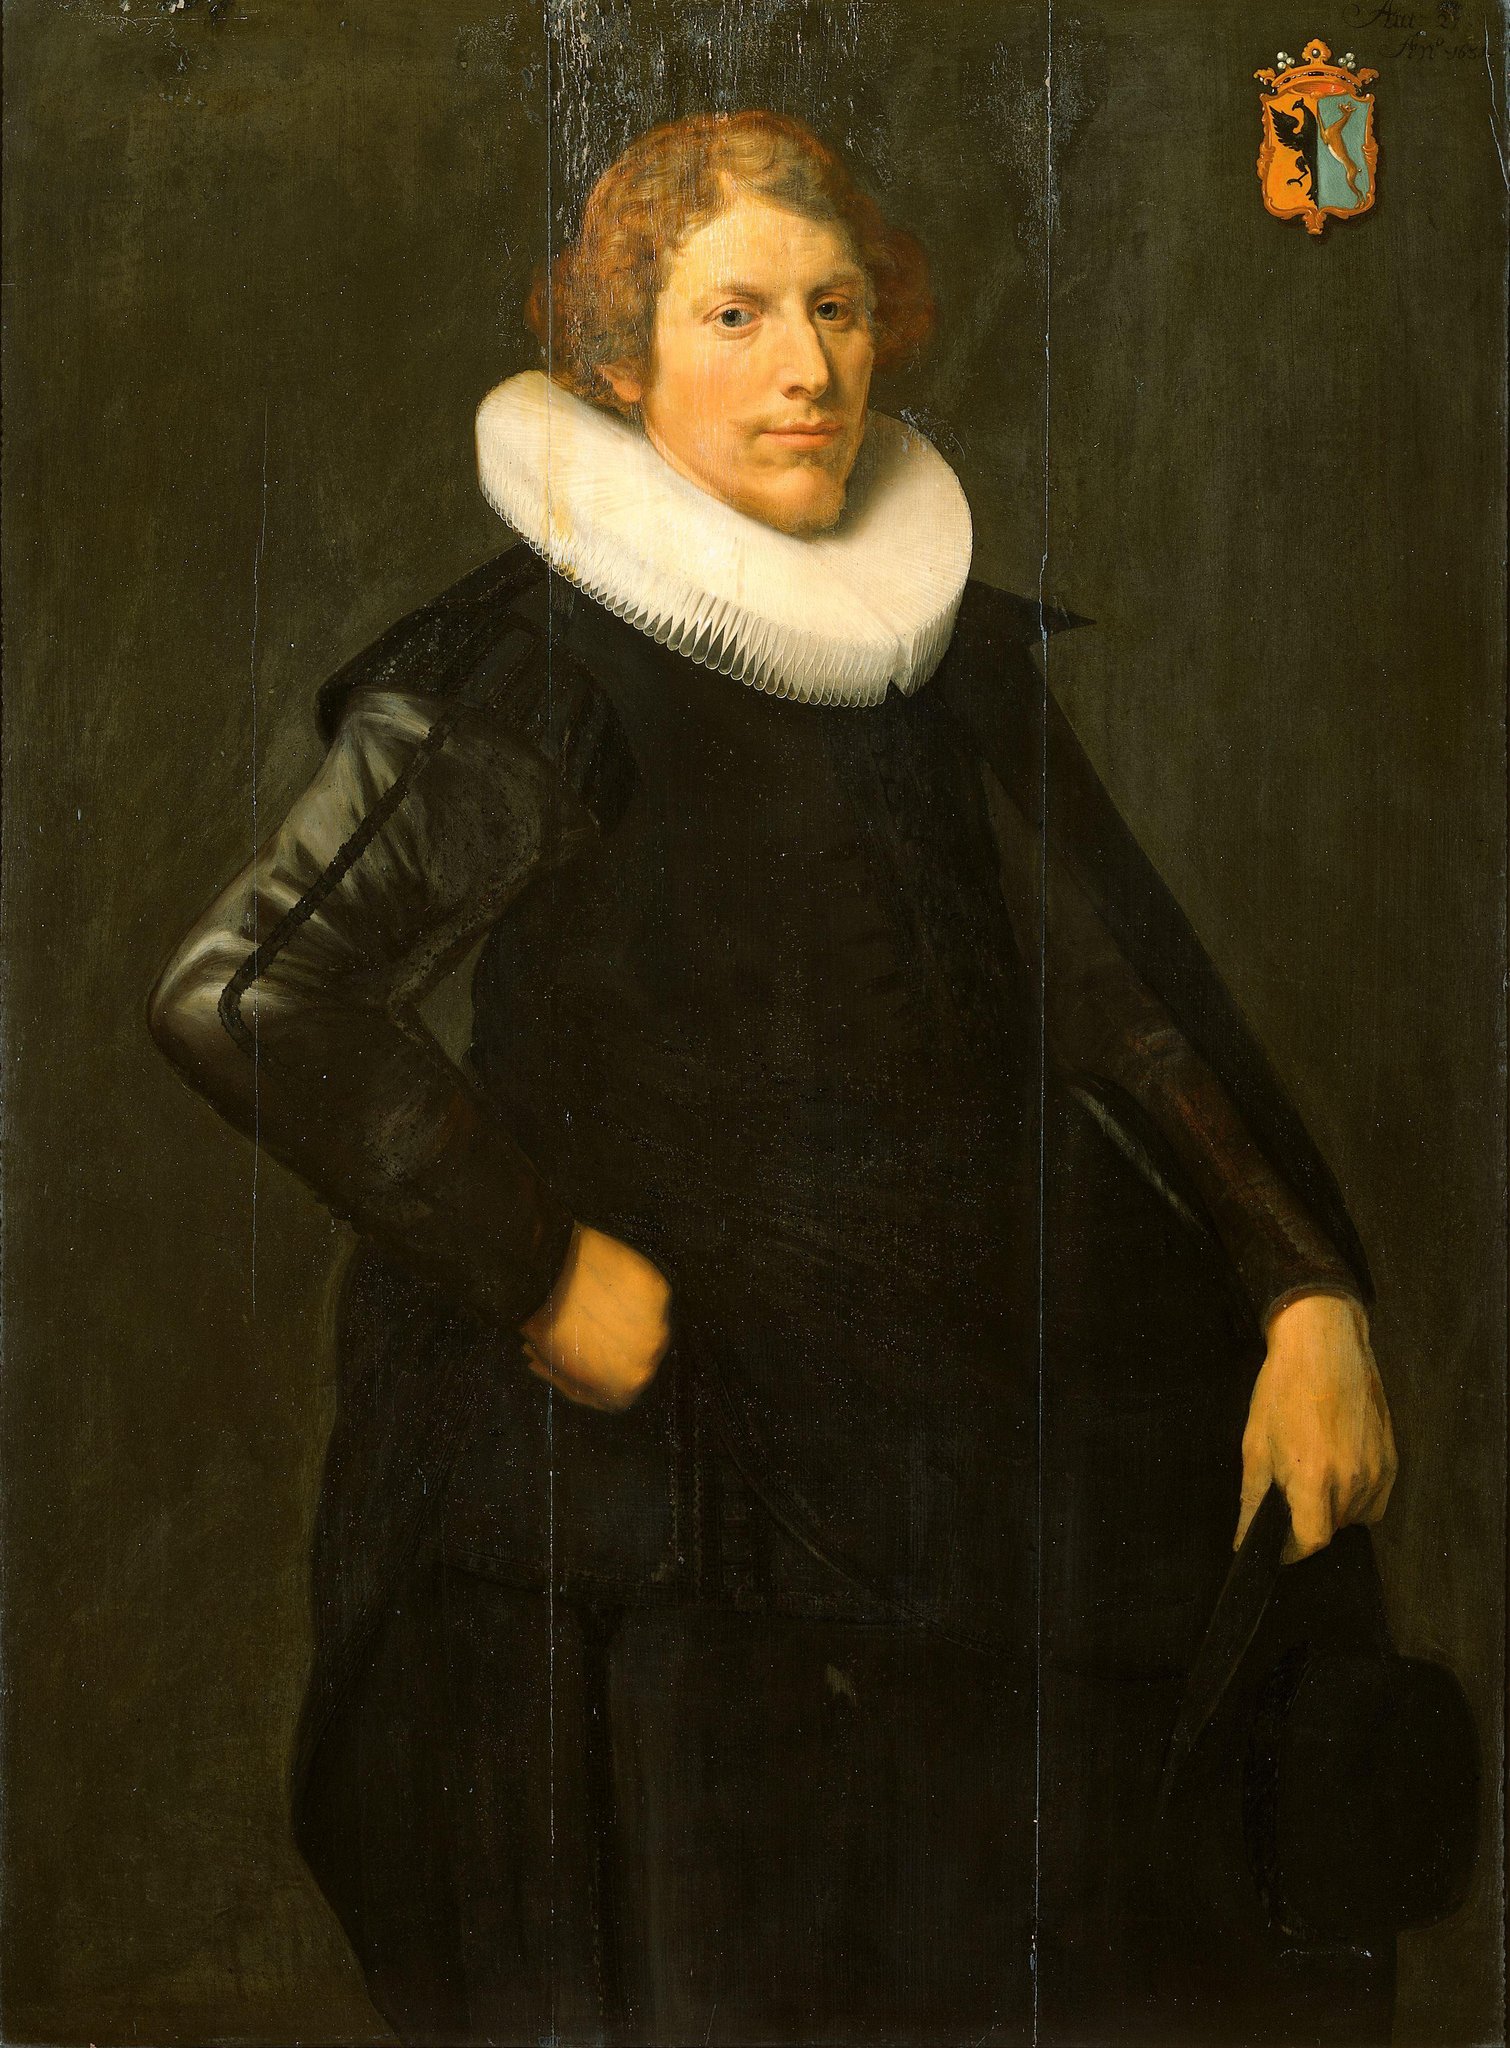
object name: painting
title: Portrait of Gerrit Ottsz Hinlopen (1603/04-1646)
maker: Anonymous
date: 1631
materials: oil, panel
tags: historical persons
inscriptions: inscription, top right, in black paint: ‘Æta . 27 .’, coat of arms, top right: per pale, a black demi-eagle displayed and couped palewise on a red ground, a red hind salient on a green ground, inscription, on the reverse: ‘Gerard Ottsz / Hinloopen’, date, top right: ‘Anº . 1631 .’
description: Portret van Gerard Ottsz Hinloopen (1603/04-46). Kniestuk, staande naar rechts, de hoed in de linkerhand, de rechterhand in de zij. Rechtsboven het familiewapen.